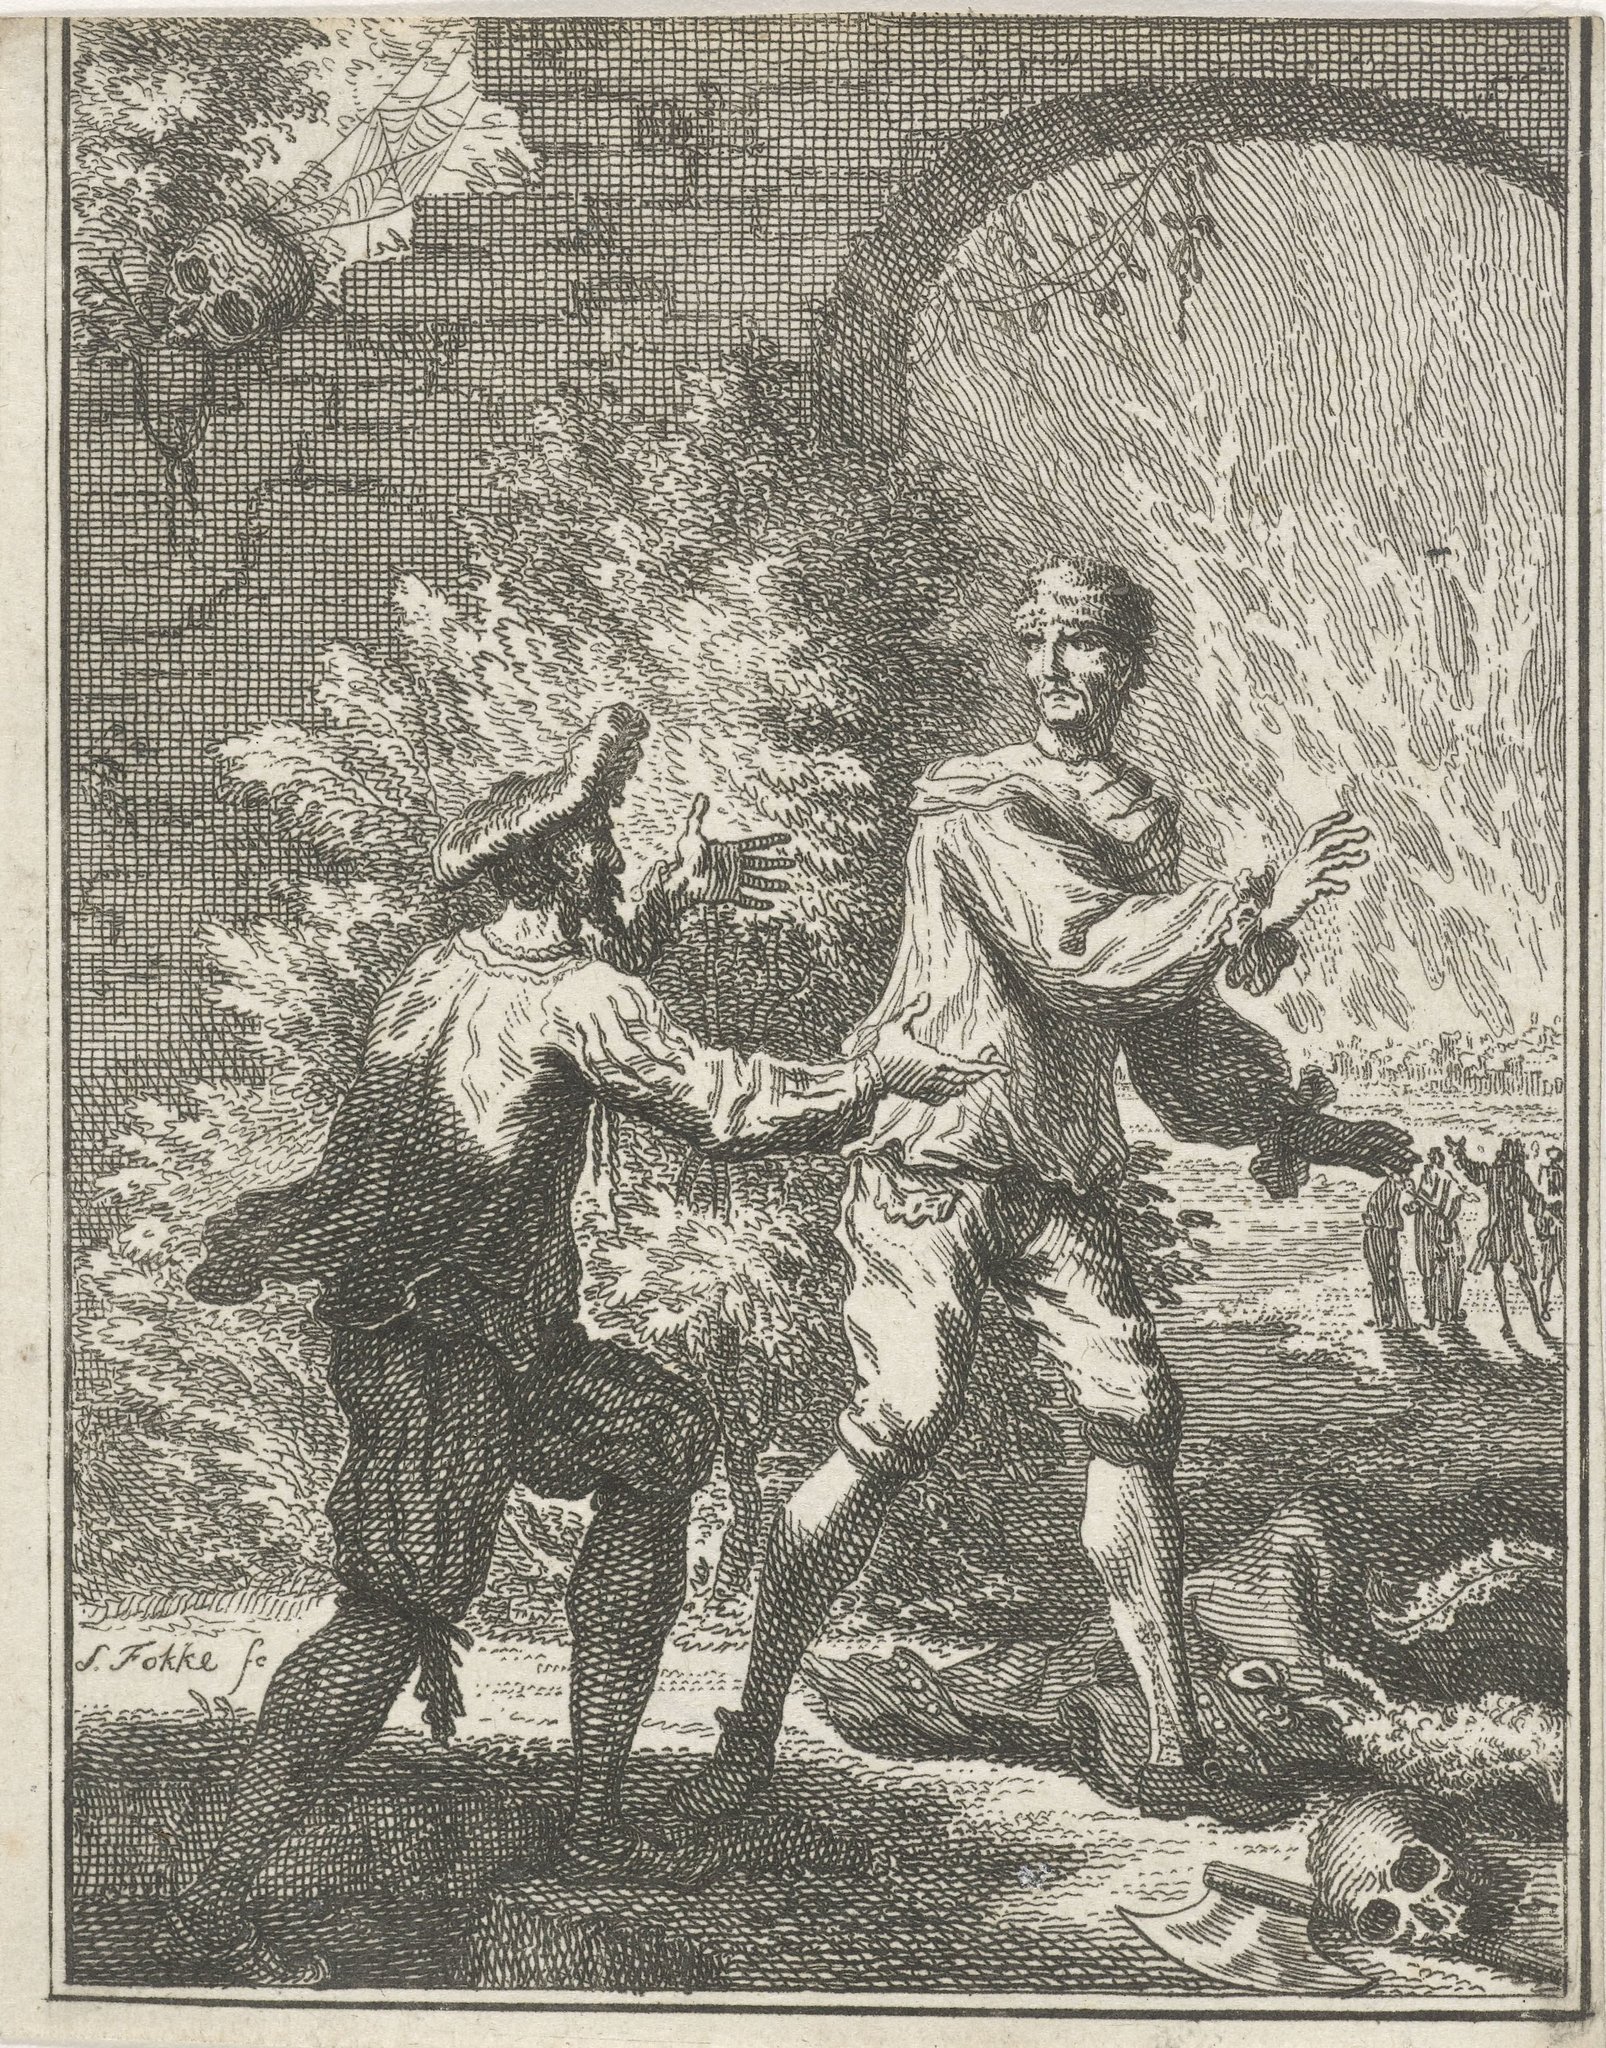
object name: print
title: Discussiërende mannen voor een poort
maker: simon fokke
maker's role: draughtsman, print maker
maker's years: 1712-1784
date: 1722-1784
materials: paper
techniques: etching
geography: amsterdam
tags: on fire, ablaze, quarrel, argument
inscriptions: collector's mark: Lugt 2228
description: Voor een poort voeren twee mannen met geheven armen een discussie. Op de grond ligt een schedel en een hakbijl. Achter de poort staan figuren die wijzen naar een grote brand in de verte.